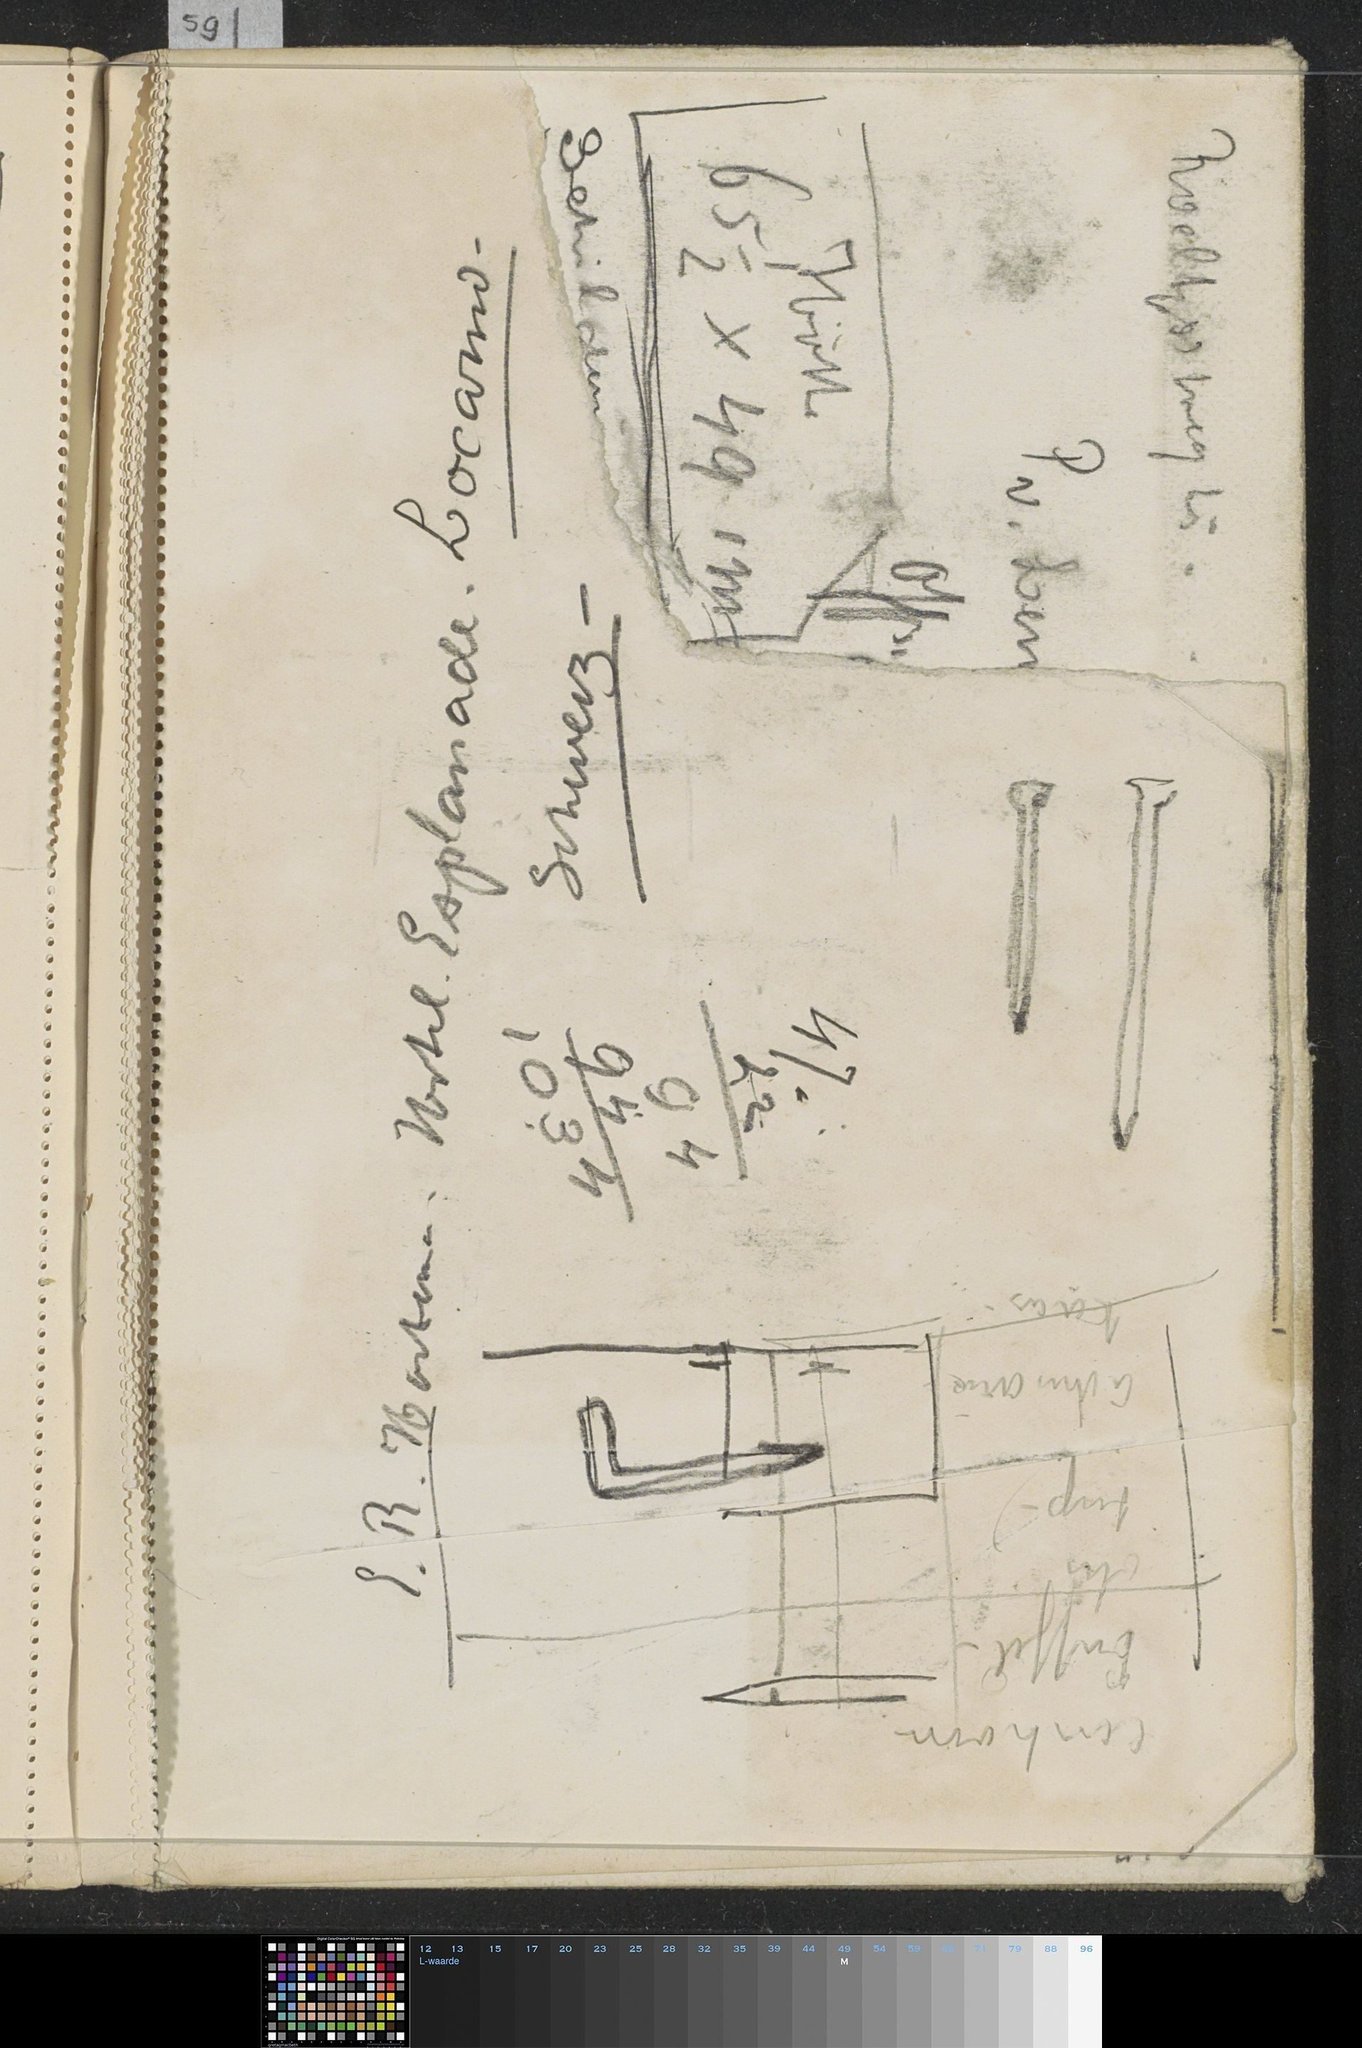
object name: sketchbook leaf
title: Spijkers en een haak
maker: cornelis vreedenburgh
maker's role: draughtsman, print maker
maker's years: 1880-1946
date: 1890-1946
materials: paper, pencil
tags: tools, aids, implements ~ crafts and industries: nail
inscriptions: annotation: ‘E.R. Hartema Hotel Esplanade Locarno/ Schweiz/ eenhoorn/ Buffel/ [...]’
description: Een deel van de bladzijde is uit het schetsboek gescheurd.